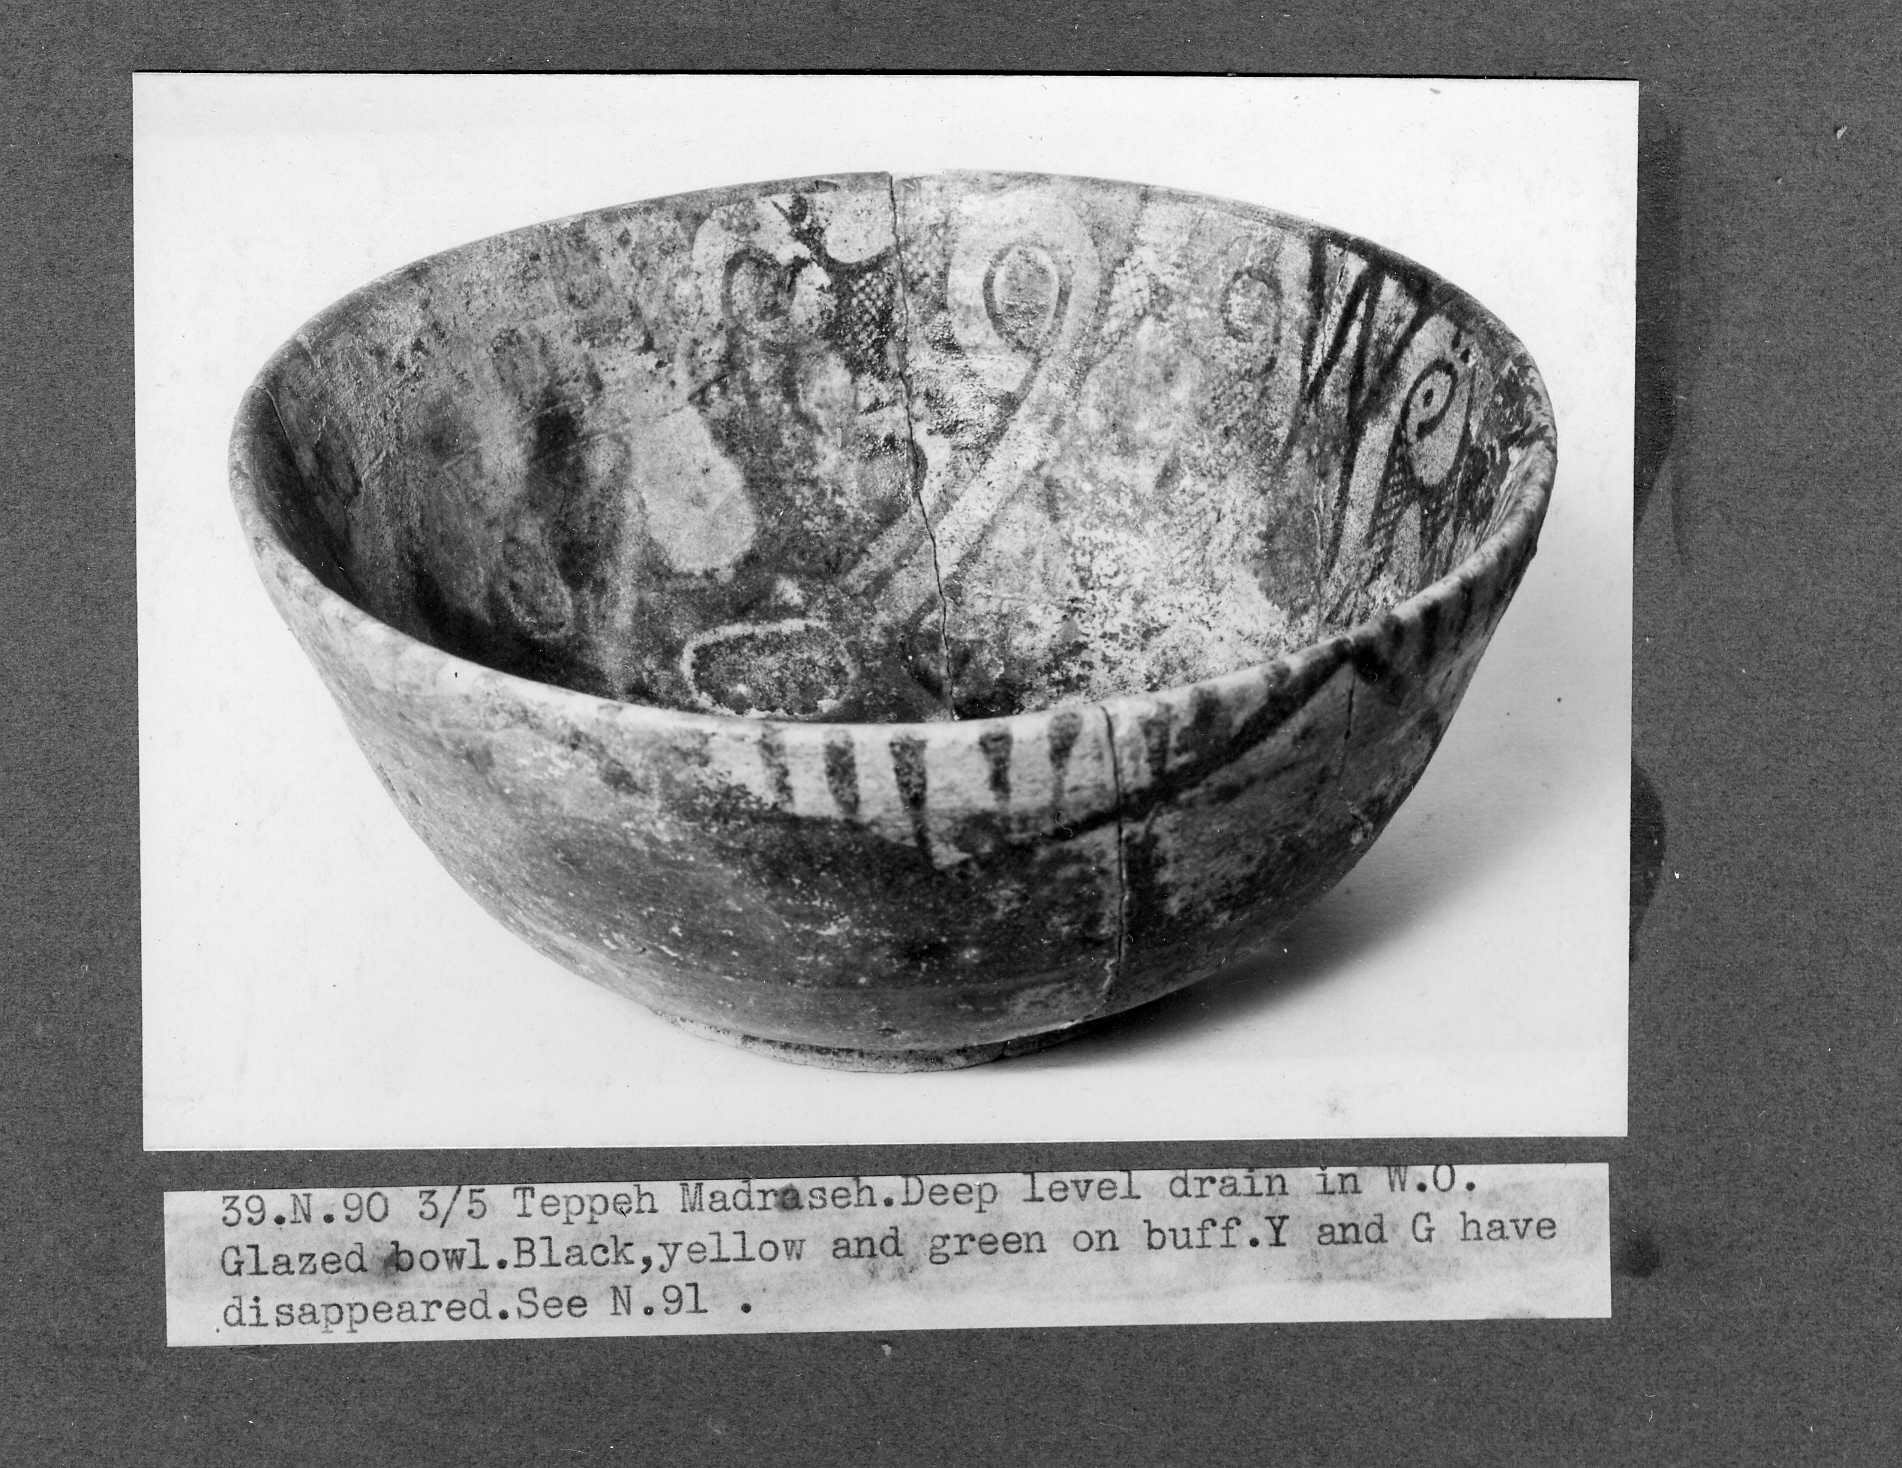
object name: bowl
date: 801-900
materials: earthenware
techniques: drawing, underglaze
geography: iran